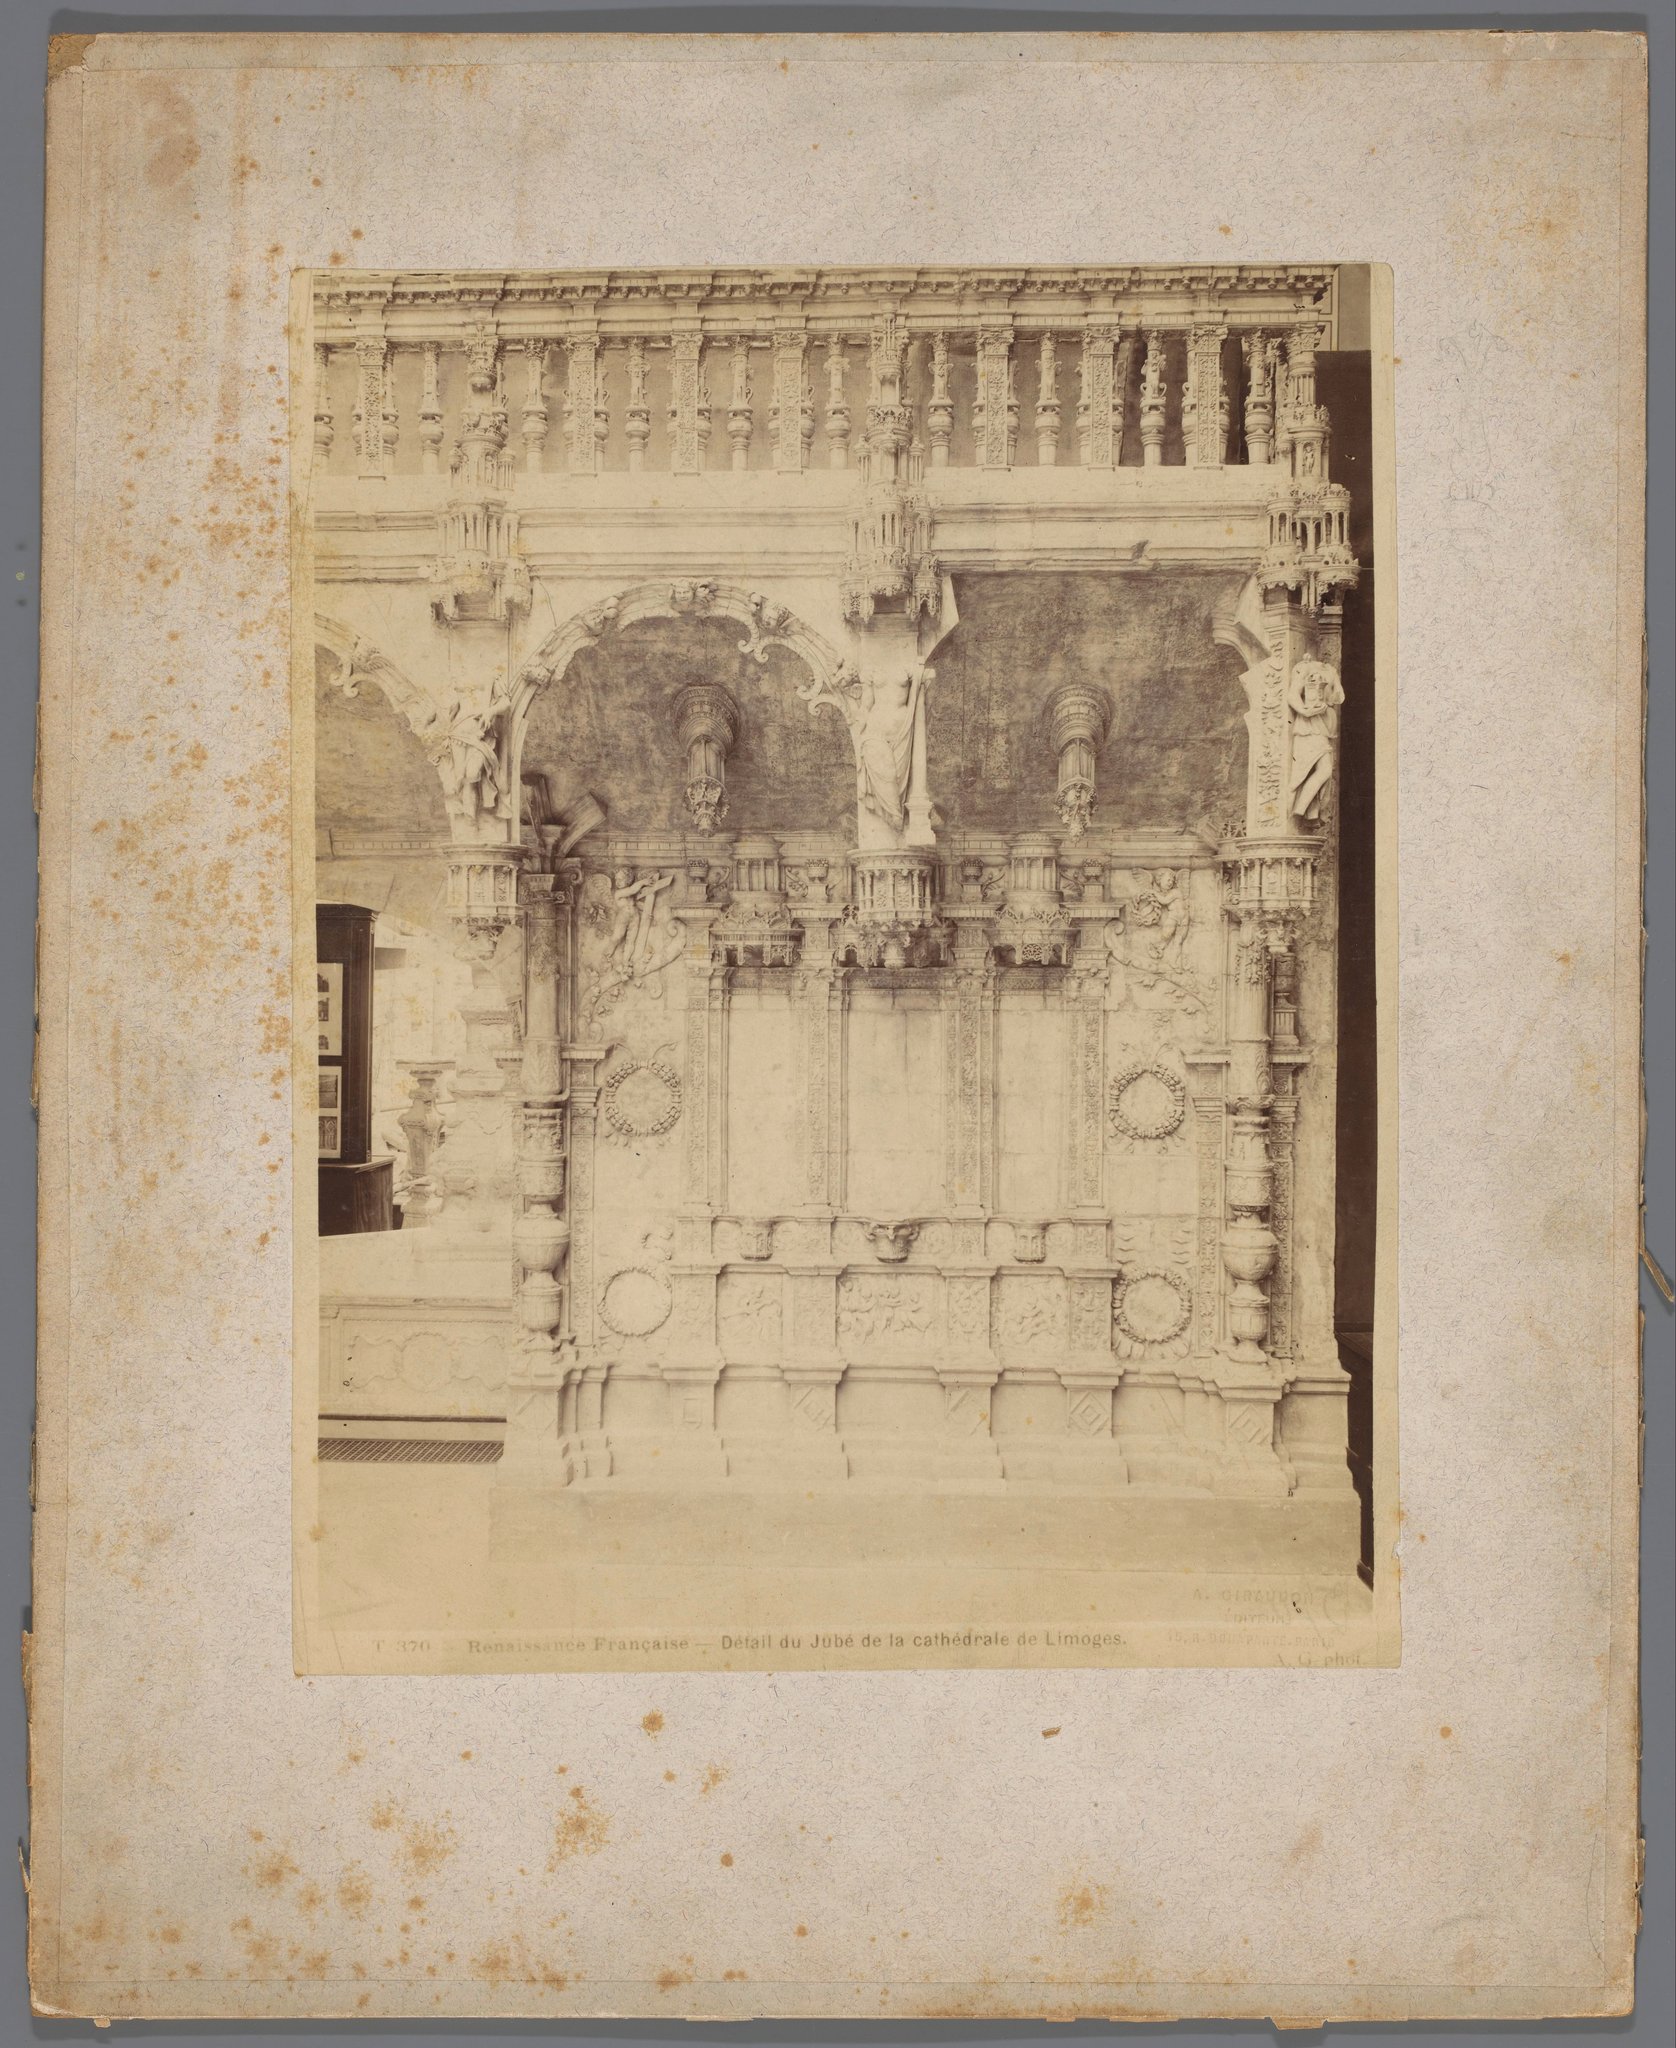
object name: photograph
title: Detail van het doksaal in de kathedraal van Limoges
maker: adolphe giraudon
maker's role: publisher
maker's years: 1849-1929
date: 1850-1900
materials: cardboard, photographic support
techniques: albumen print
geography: limoges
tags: church (exterior)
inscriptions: inscription: ‘T 370 . Renaissance Française’, collector's mark: ‘Rijks-normaalschool voor teekenonderwijzers Amsterdam’ Lugt 3937, workshop stamp: ‘A. Giraudon/ Editeur/ 15. R. Bonaparte. Paris’